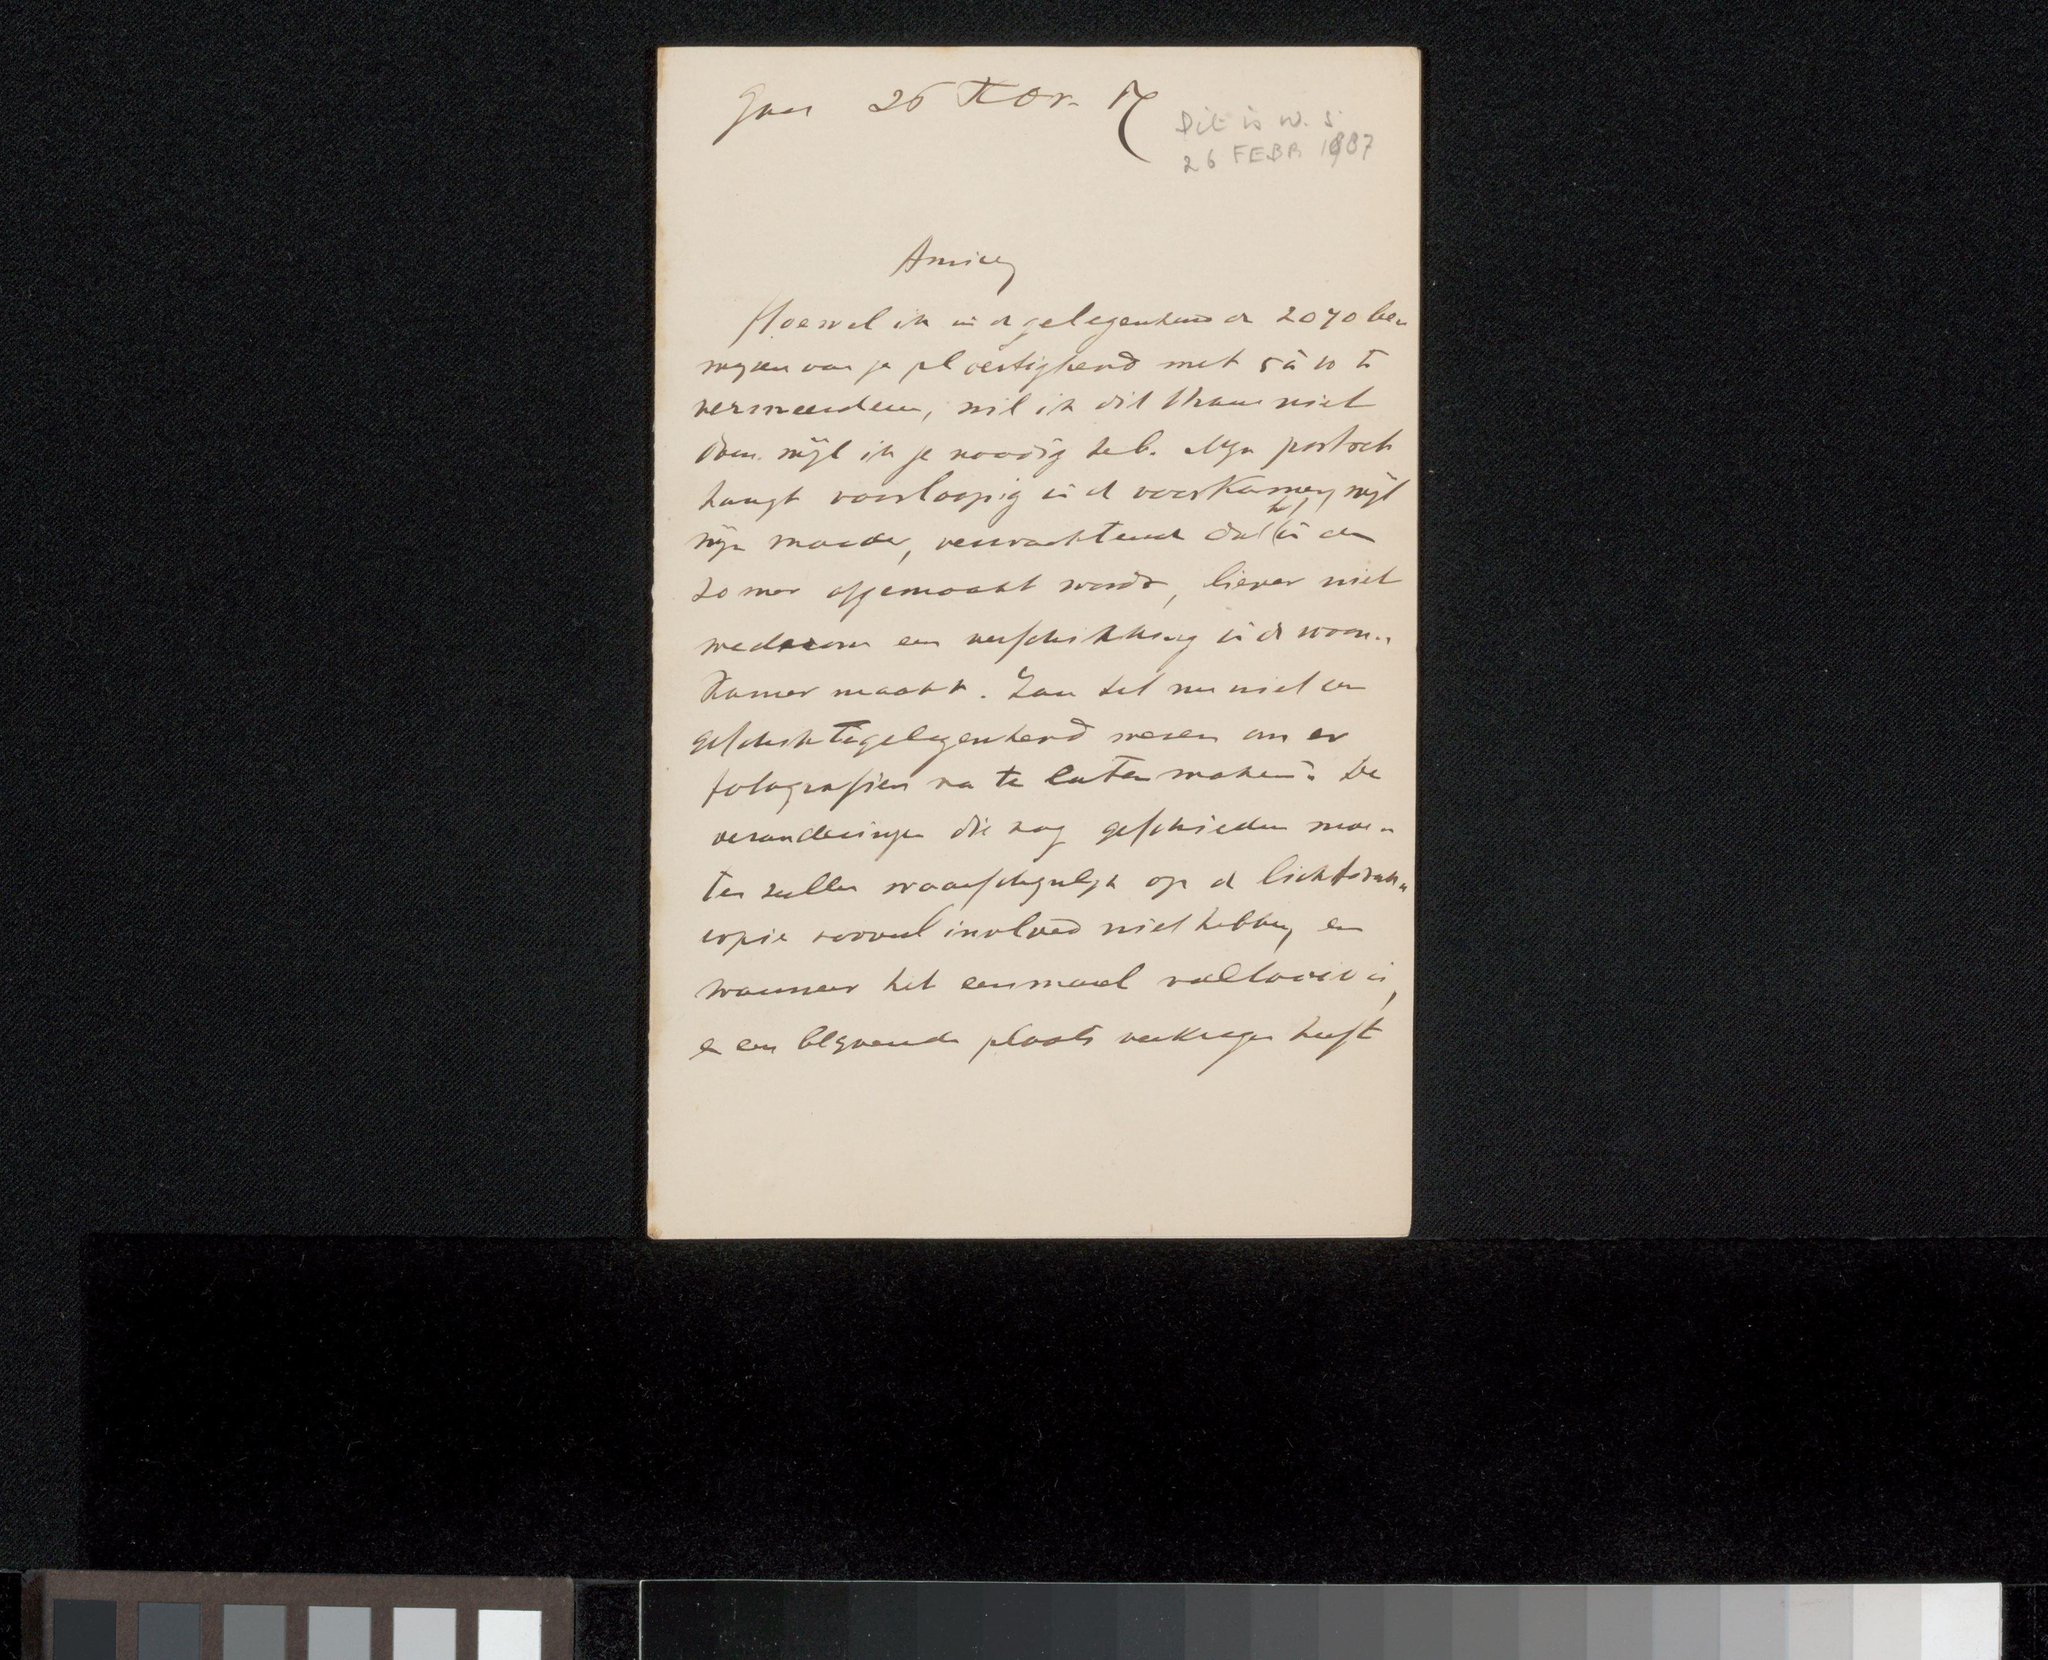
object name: letter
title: Brief aan Jan Veth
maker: chap van deventer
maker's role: kunstcriticus, scheikundige, schrijver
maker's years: 1860-1931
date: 1887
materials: ink, paper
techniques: pen, writing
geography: goes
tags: dordrecht, amsterdam, painter, print maker, draughtsman, designer, jan veth, photography, cinematography, historical persons (portraits and scenes from the life)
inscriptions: collector's mark: ‘RPK’, watermark